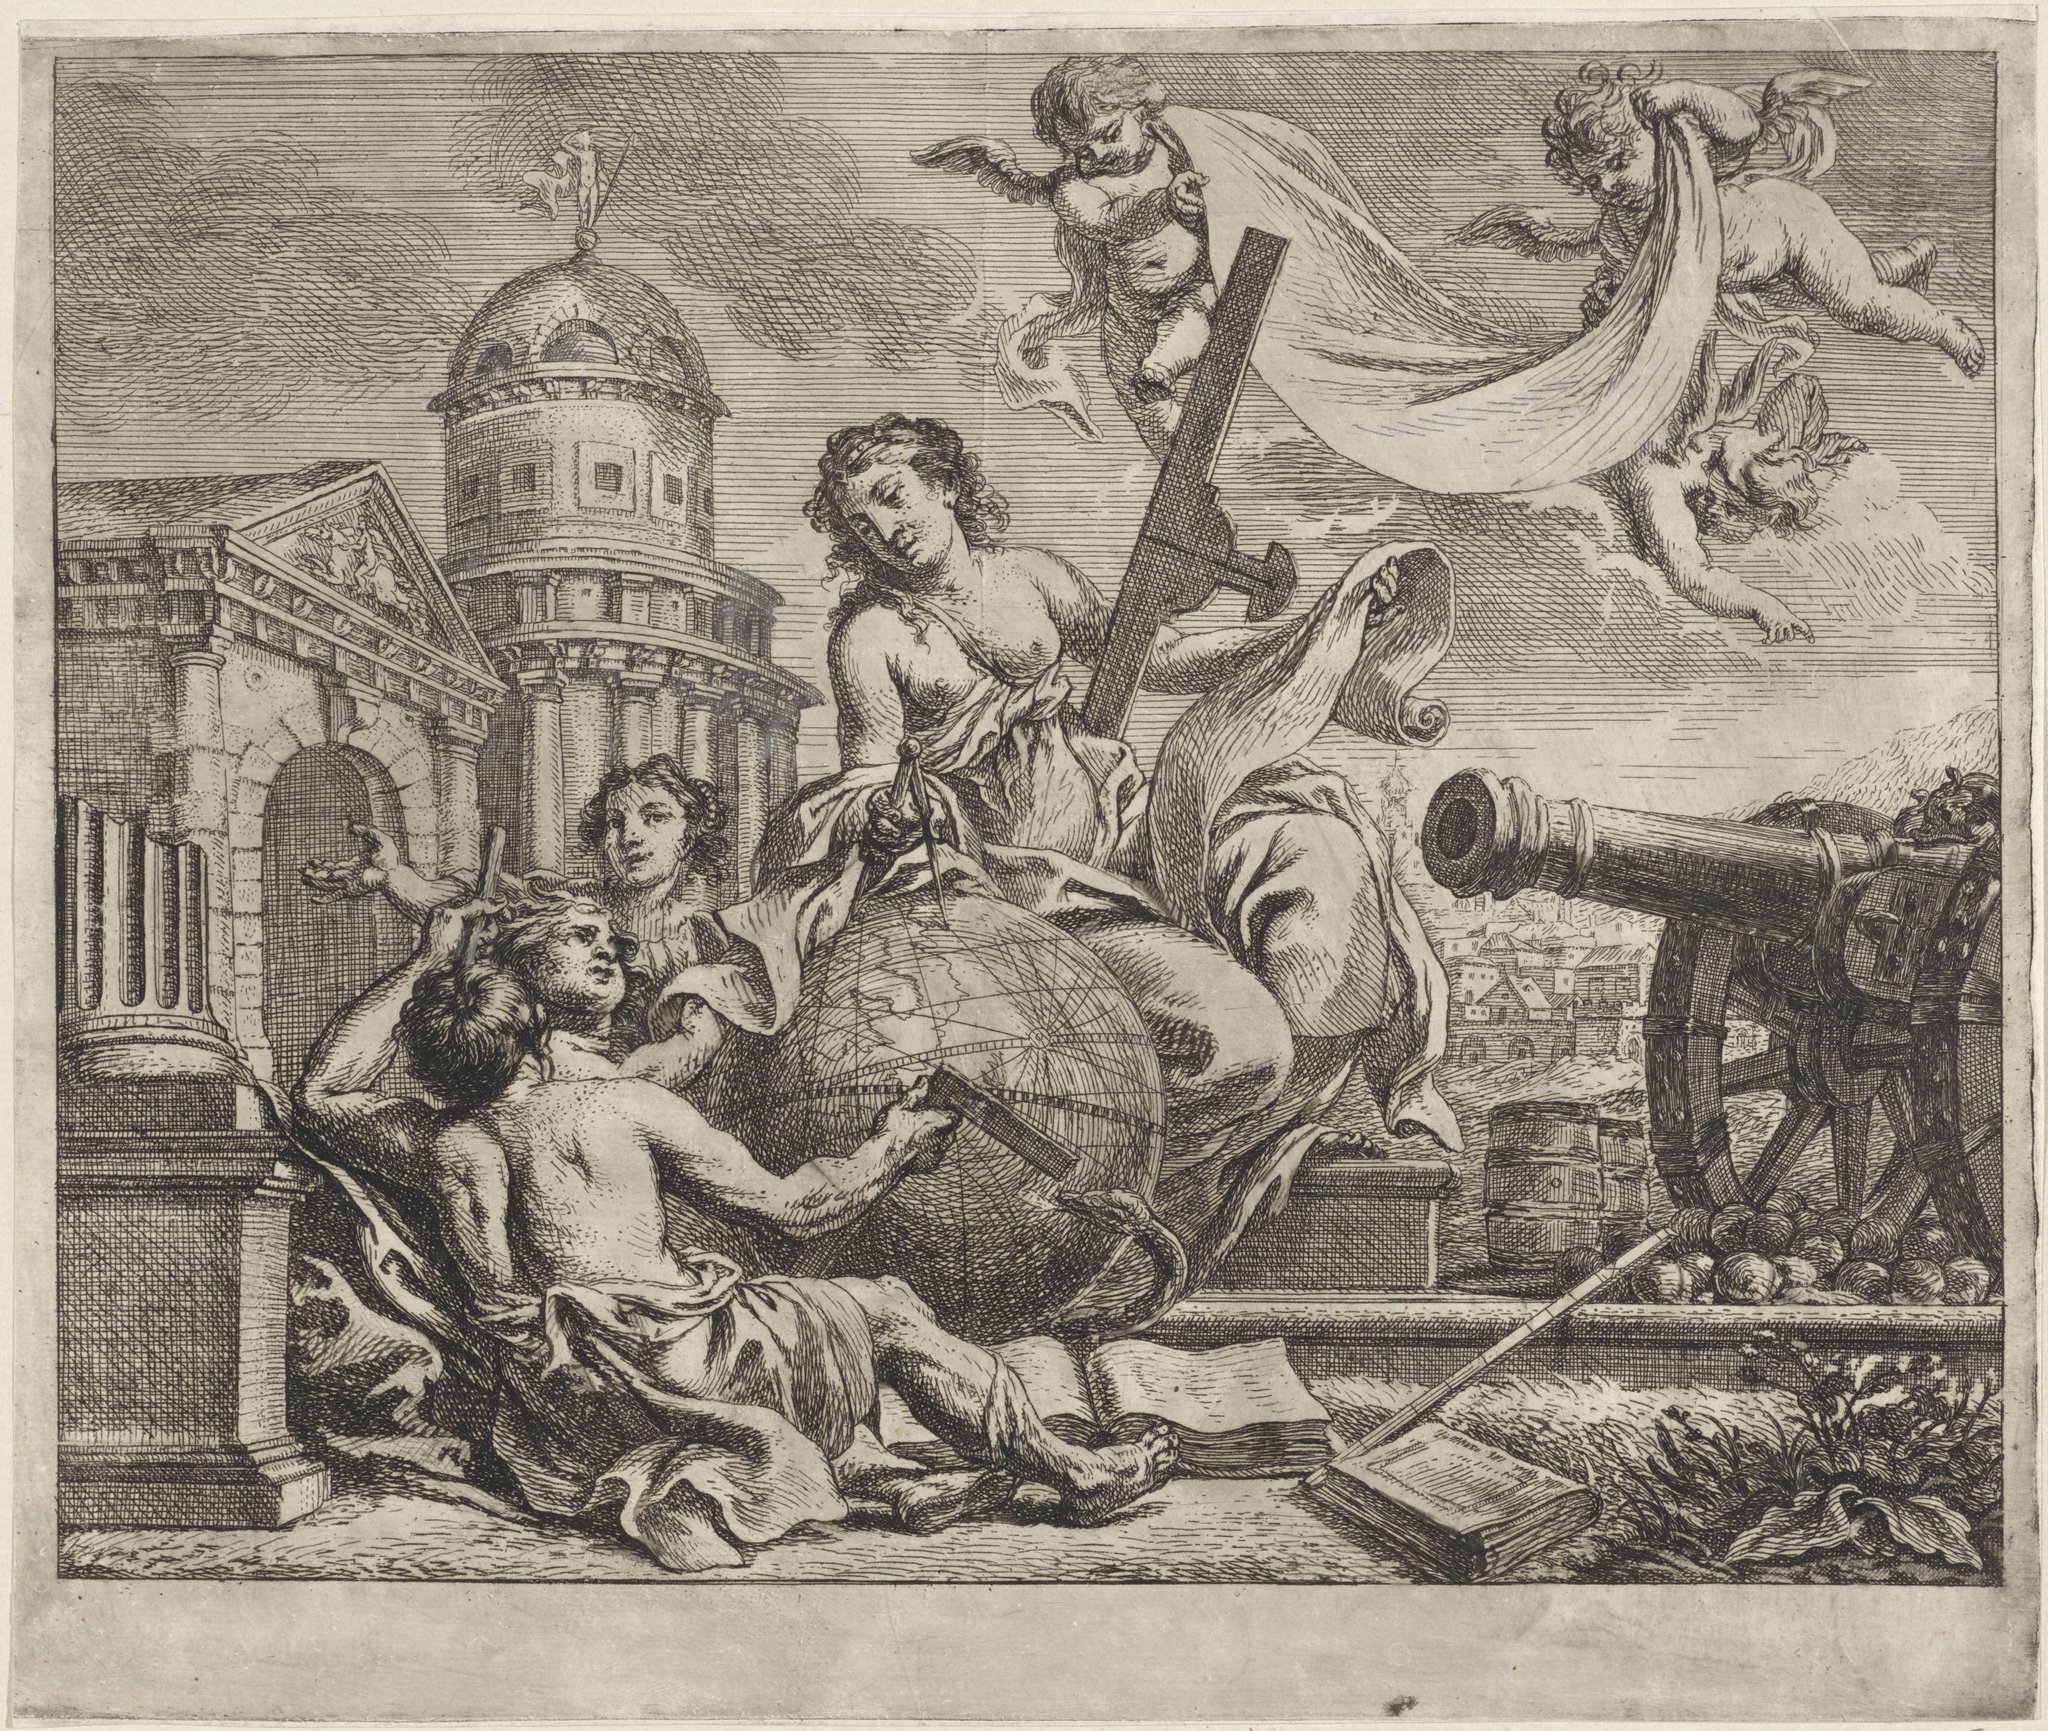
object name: print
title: De zeven vrije kunsten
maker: cornelis schut (i)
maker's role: draughtsman, print maker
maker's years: 1597-1655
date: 1618-1655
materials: paint, ink, paper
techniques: brush, engraving, etching, pen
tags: snakes, 'geometria' (~ quadrivium); 'geometria' (ripa), measuring-instruments, globe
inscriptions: collector's mark: Lugt 240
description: Tegen een achtergrond van klassieke gebouwen meet Geometria een wereldbol met een passer. Op de grond zit een man die, net als Geometria, meetinstrumenten in zijn handen houdt. Een vrouw gebaart richting de gebouwen op de achtergrond. Links staat een kanon, op de grond liggen boeken en een duimstok. Een slang krult zich rondom de wereldbol.